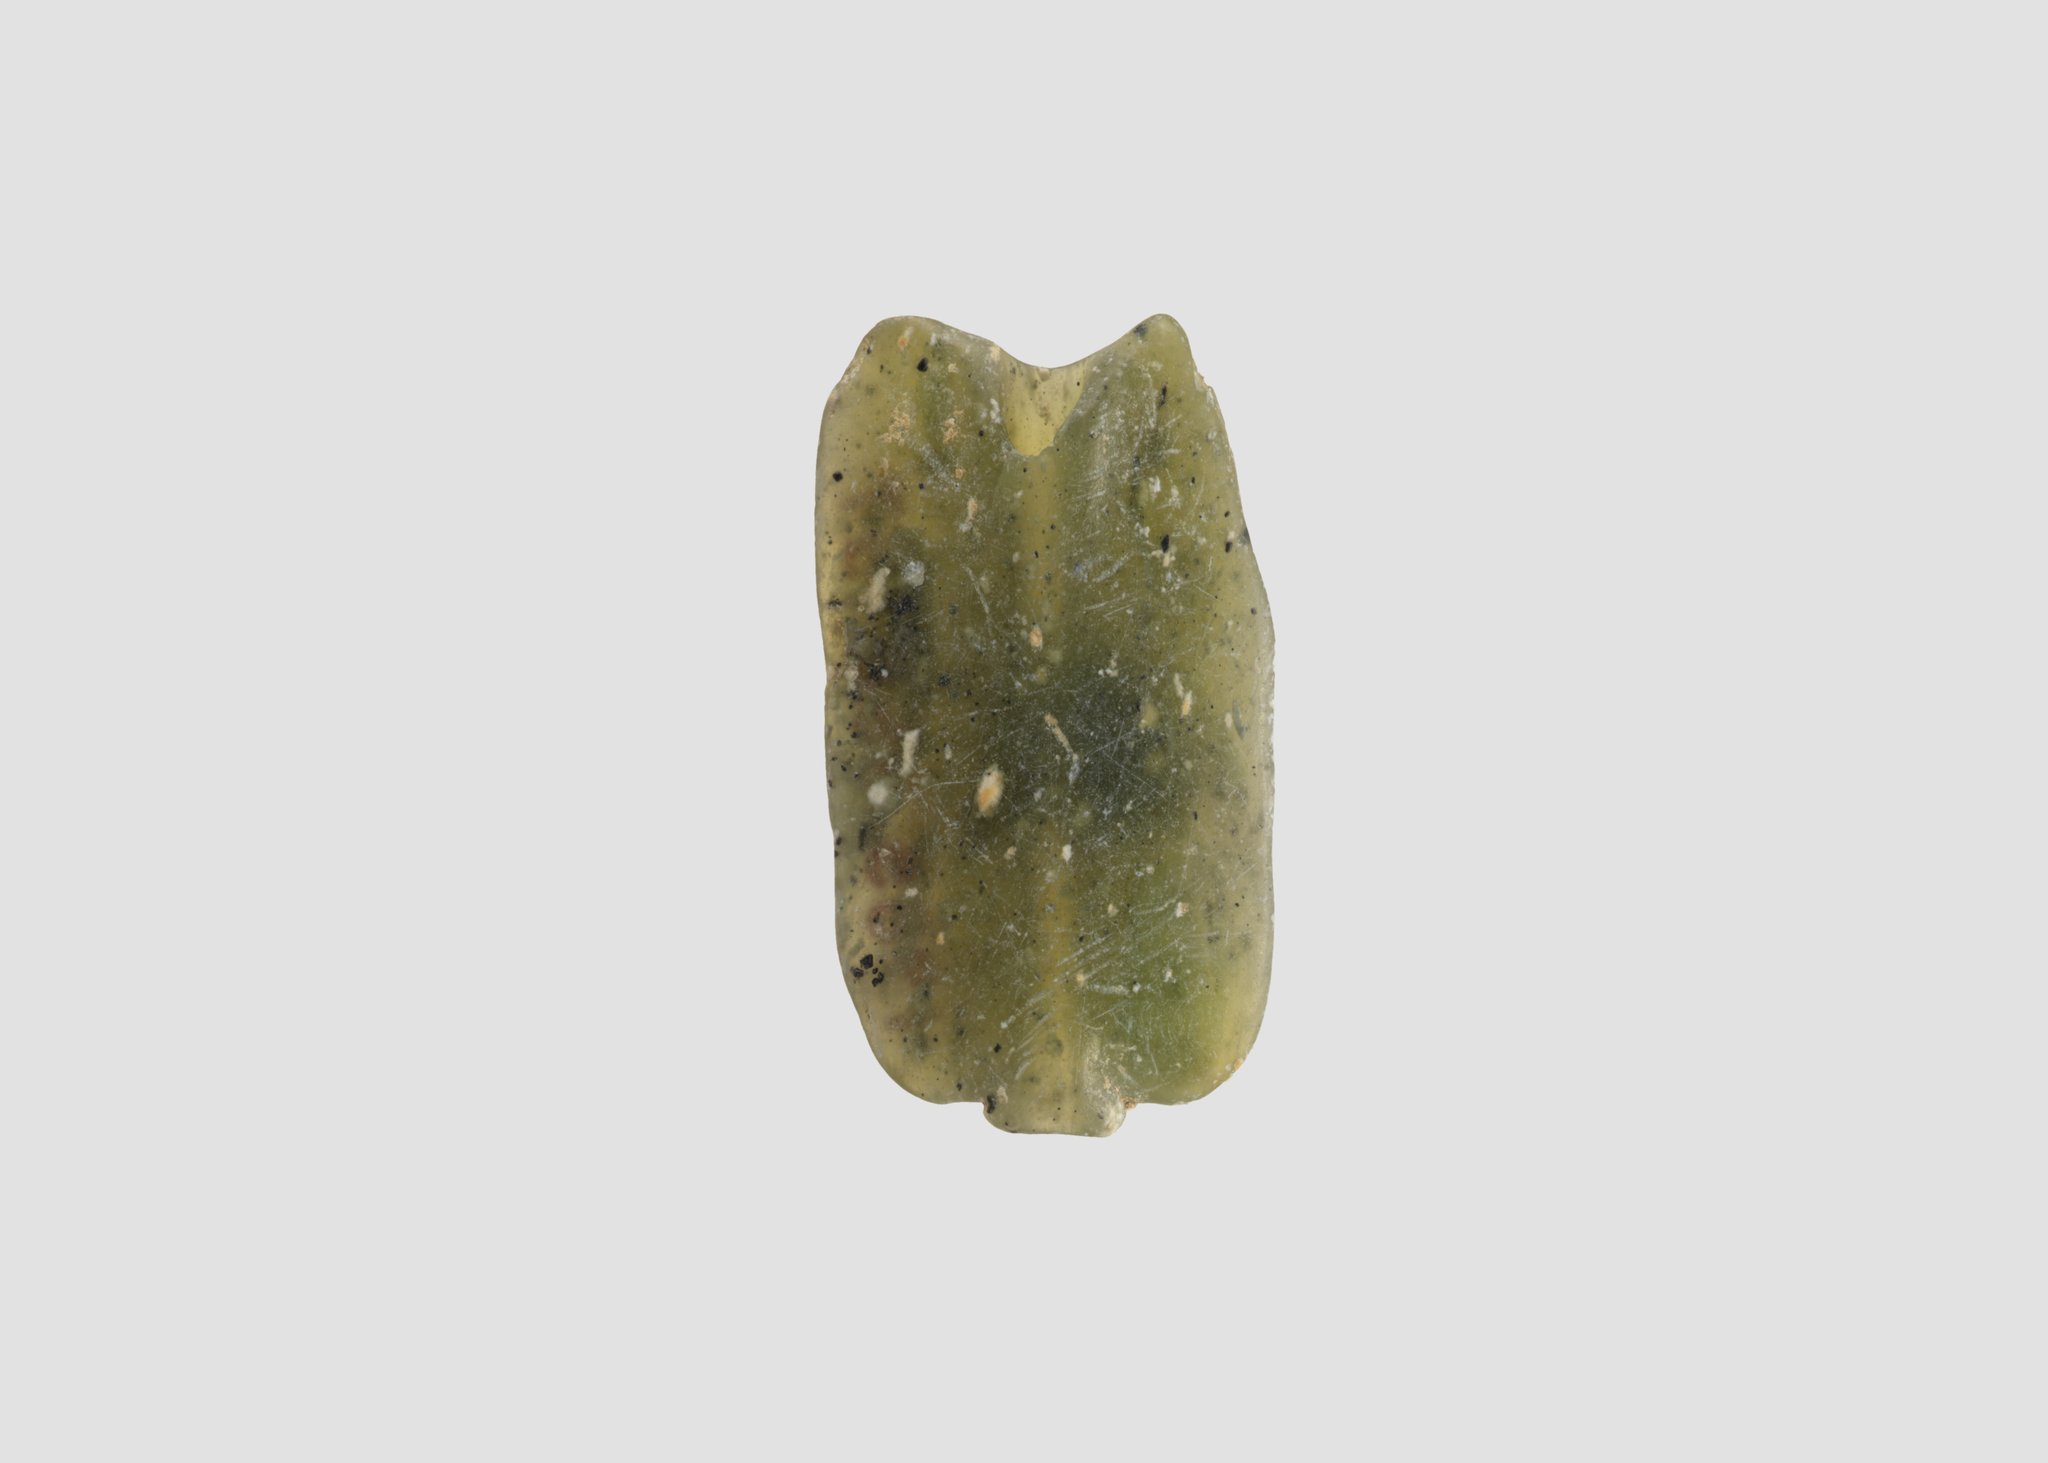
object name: bead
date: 7000-5001 BCE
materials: mineral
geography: syria